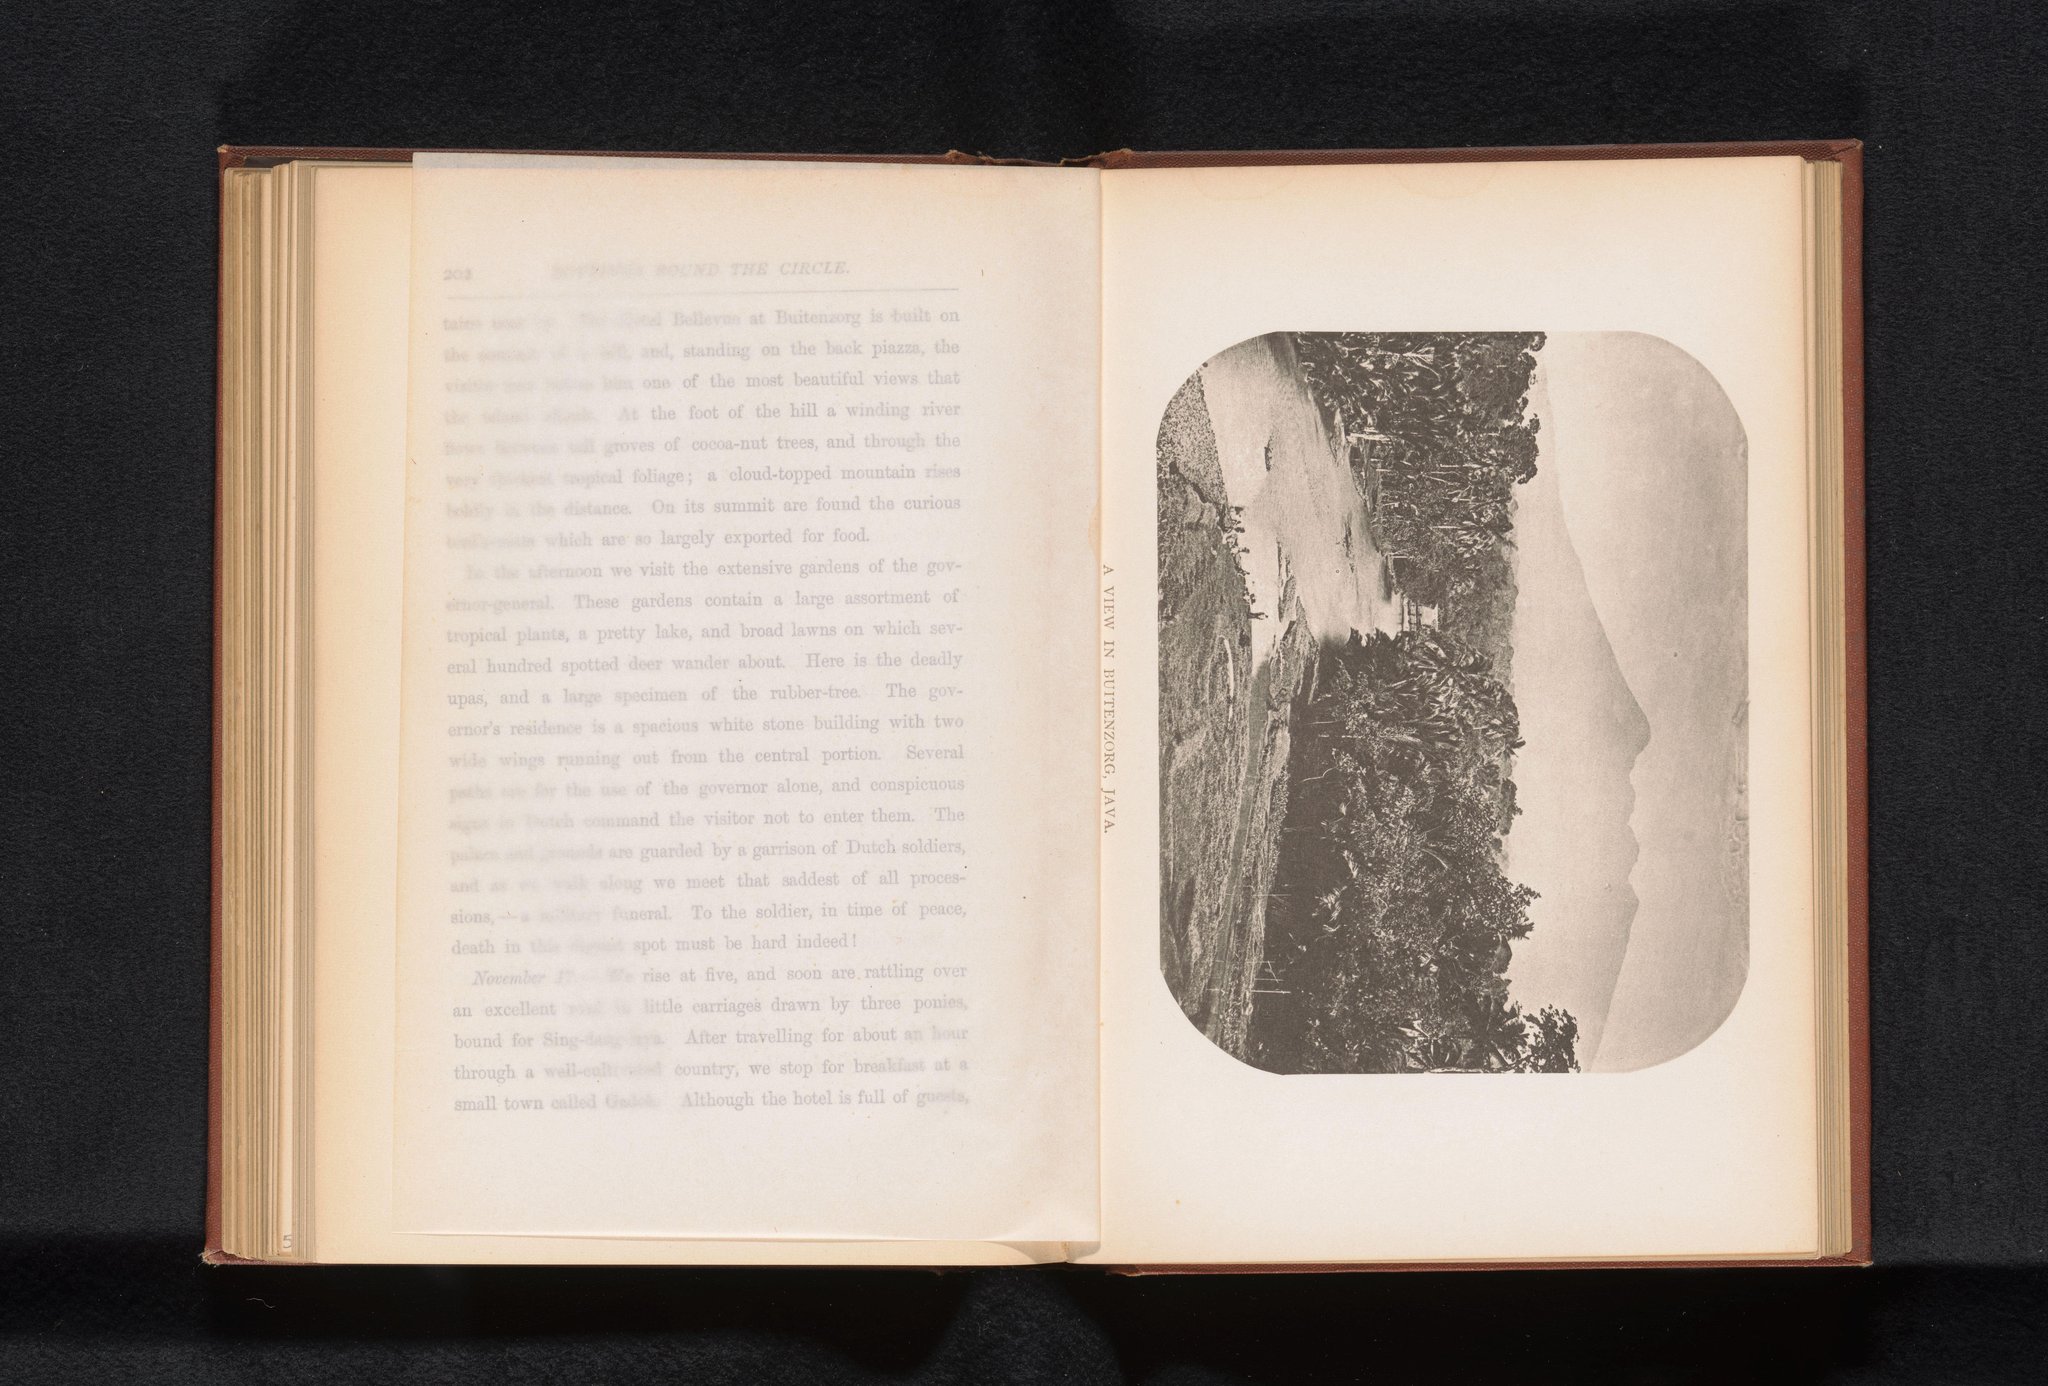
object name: page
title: A view in Buitenzorg, Java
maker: Anonymous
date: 1866-1876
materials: paper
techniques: photoaquatint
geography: buitenzorg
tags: river, mountains